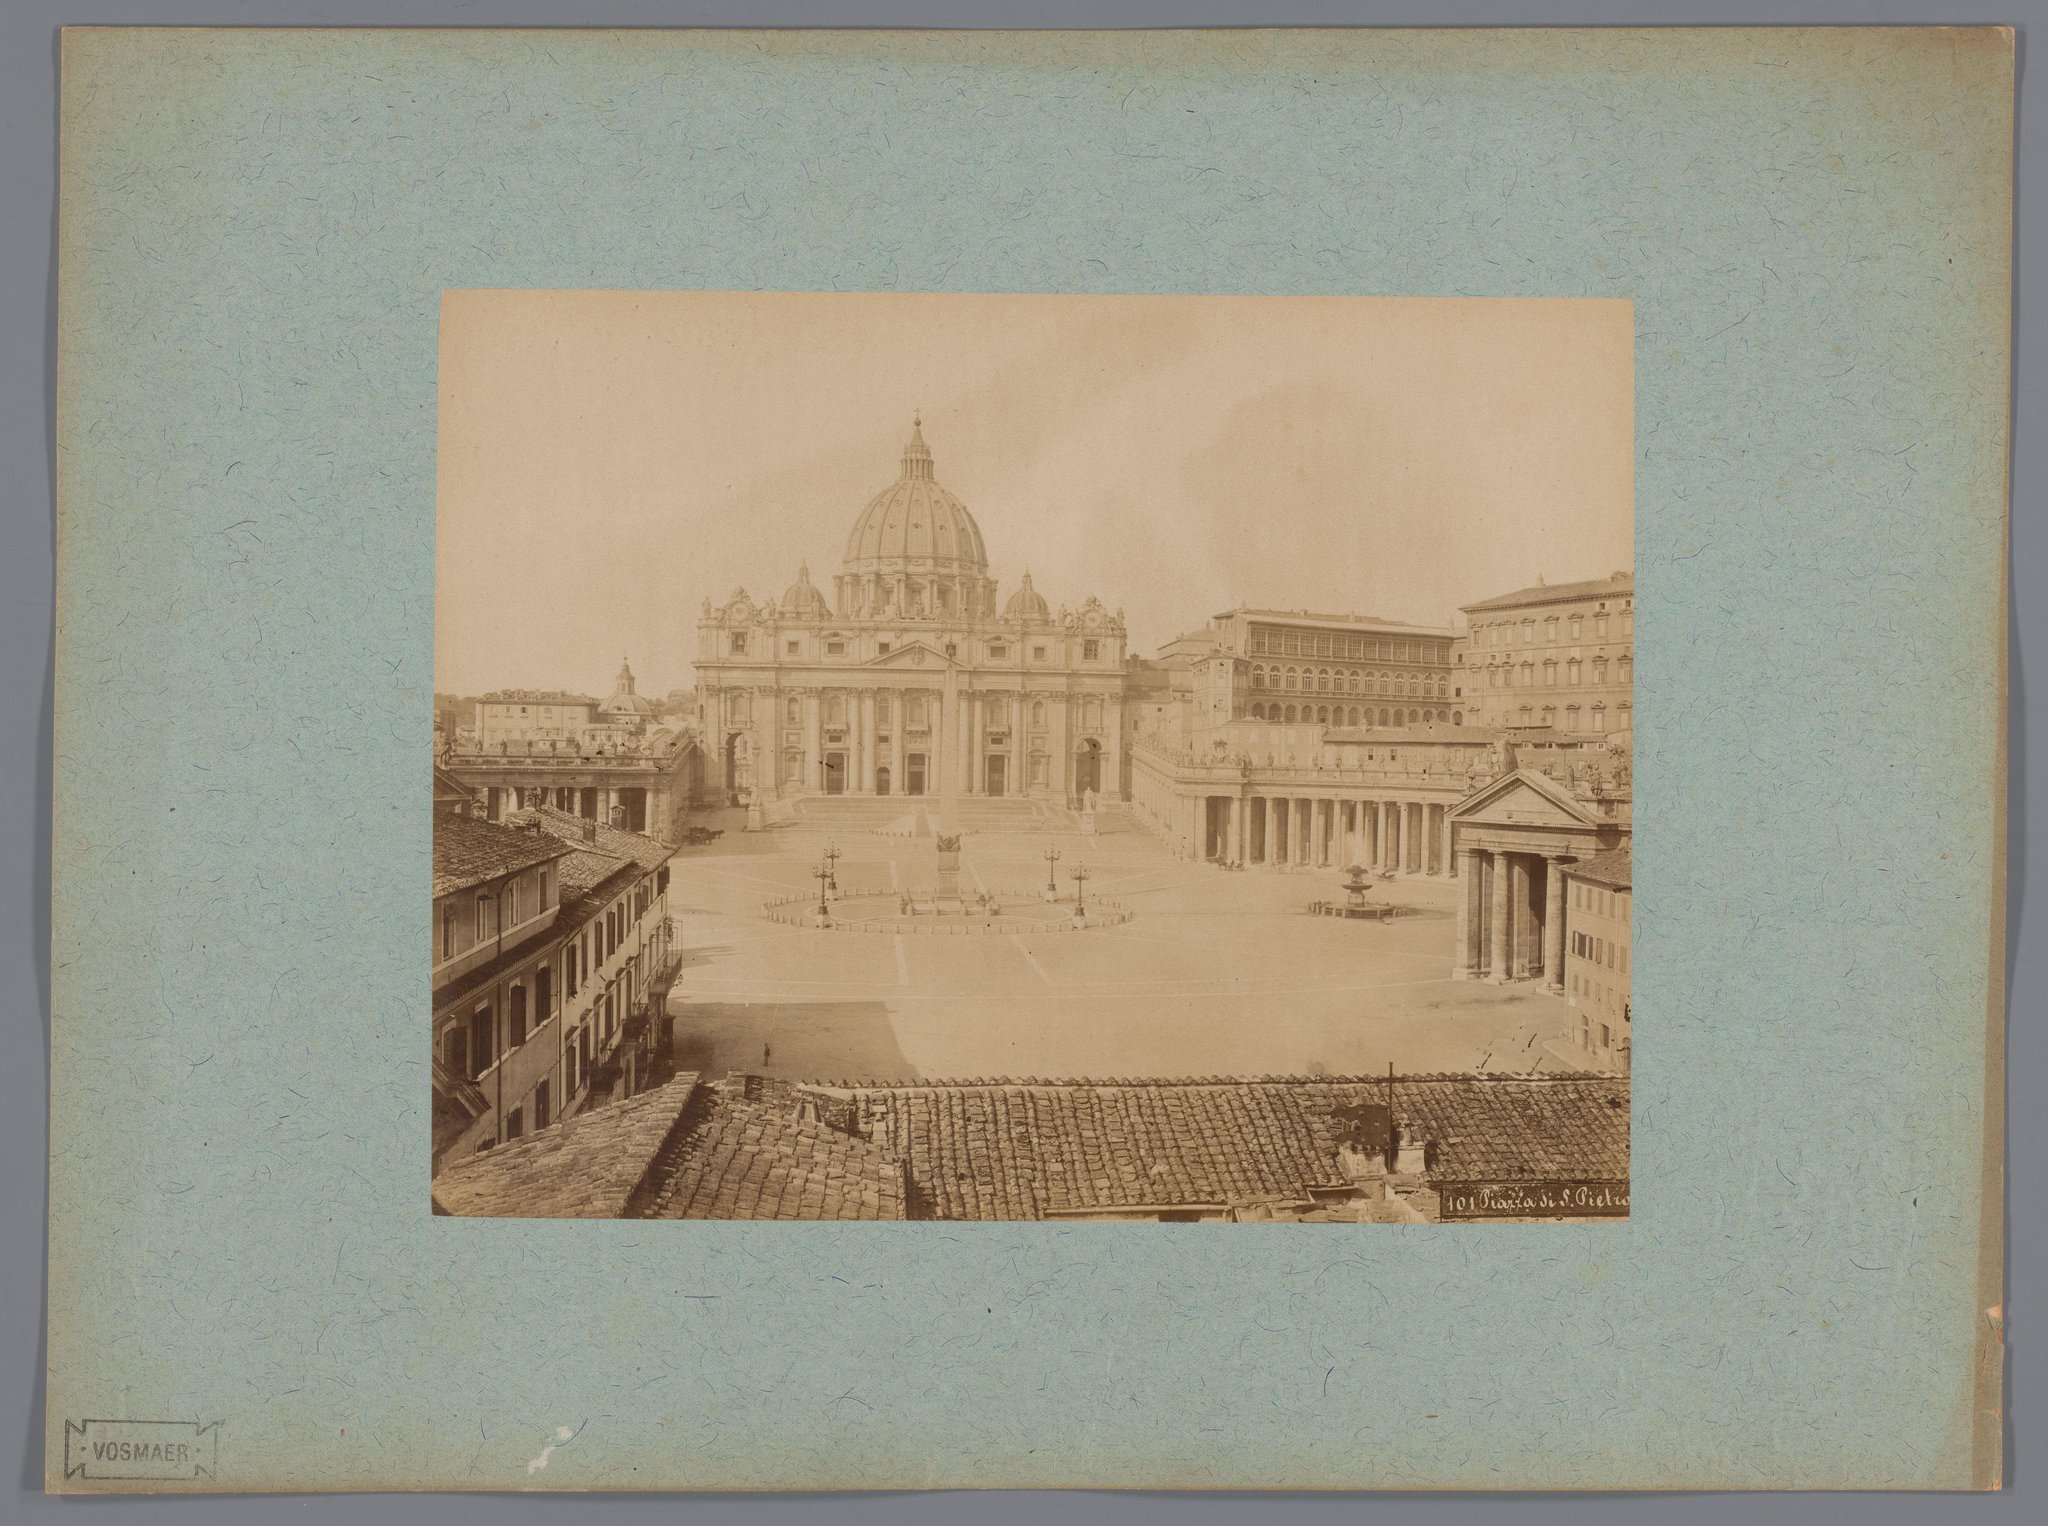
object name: photograph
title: Gezicht op de Sint-Pieterbasiliek en het Sint-Pietersplein te Vaticaanstad, Italië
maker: Anonymous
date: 1851-1900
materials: cardboard, paper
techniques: albumen print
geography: vatican city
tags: square, place, circus, etc., church (exterior)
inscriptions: collector's mark: ‘VOSMAER’, number: ‘101’